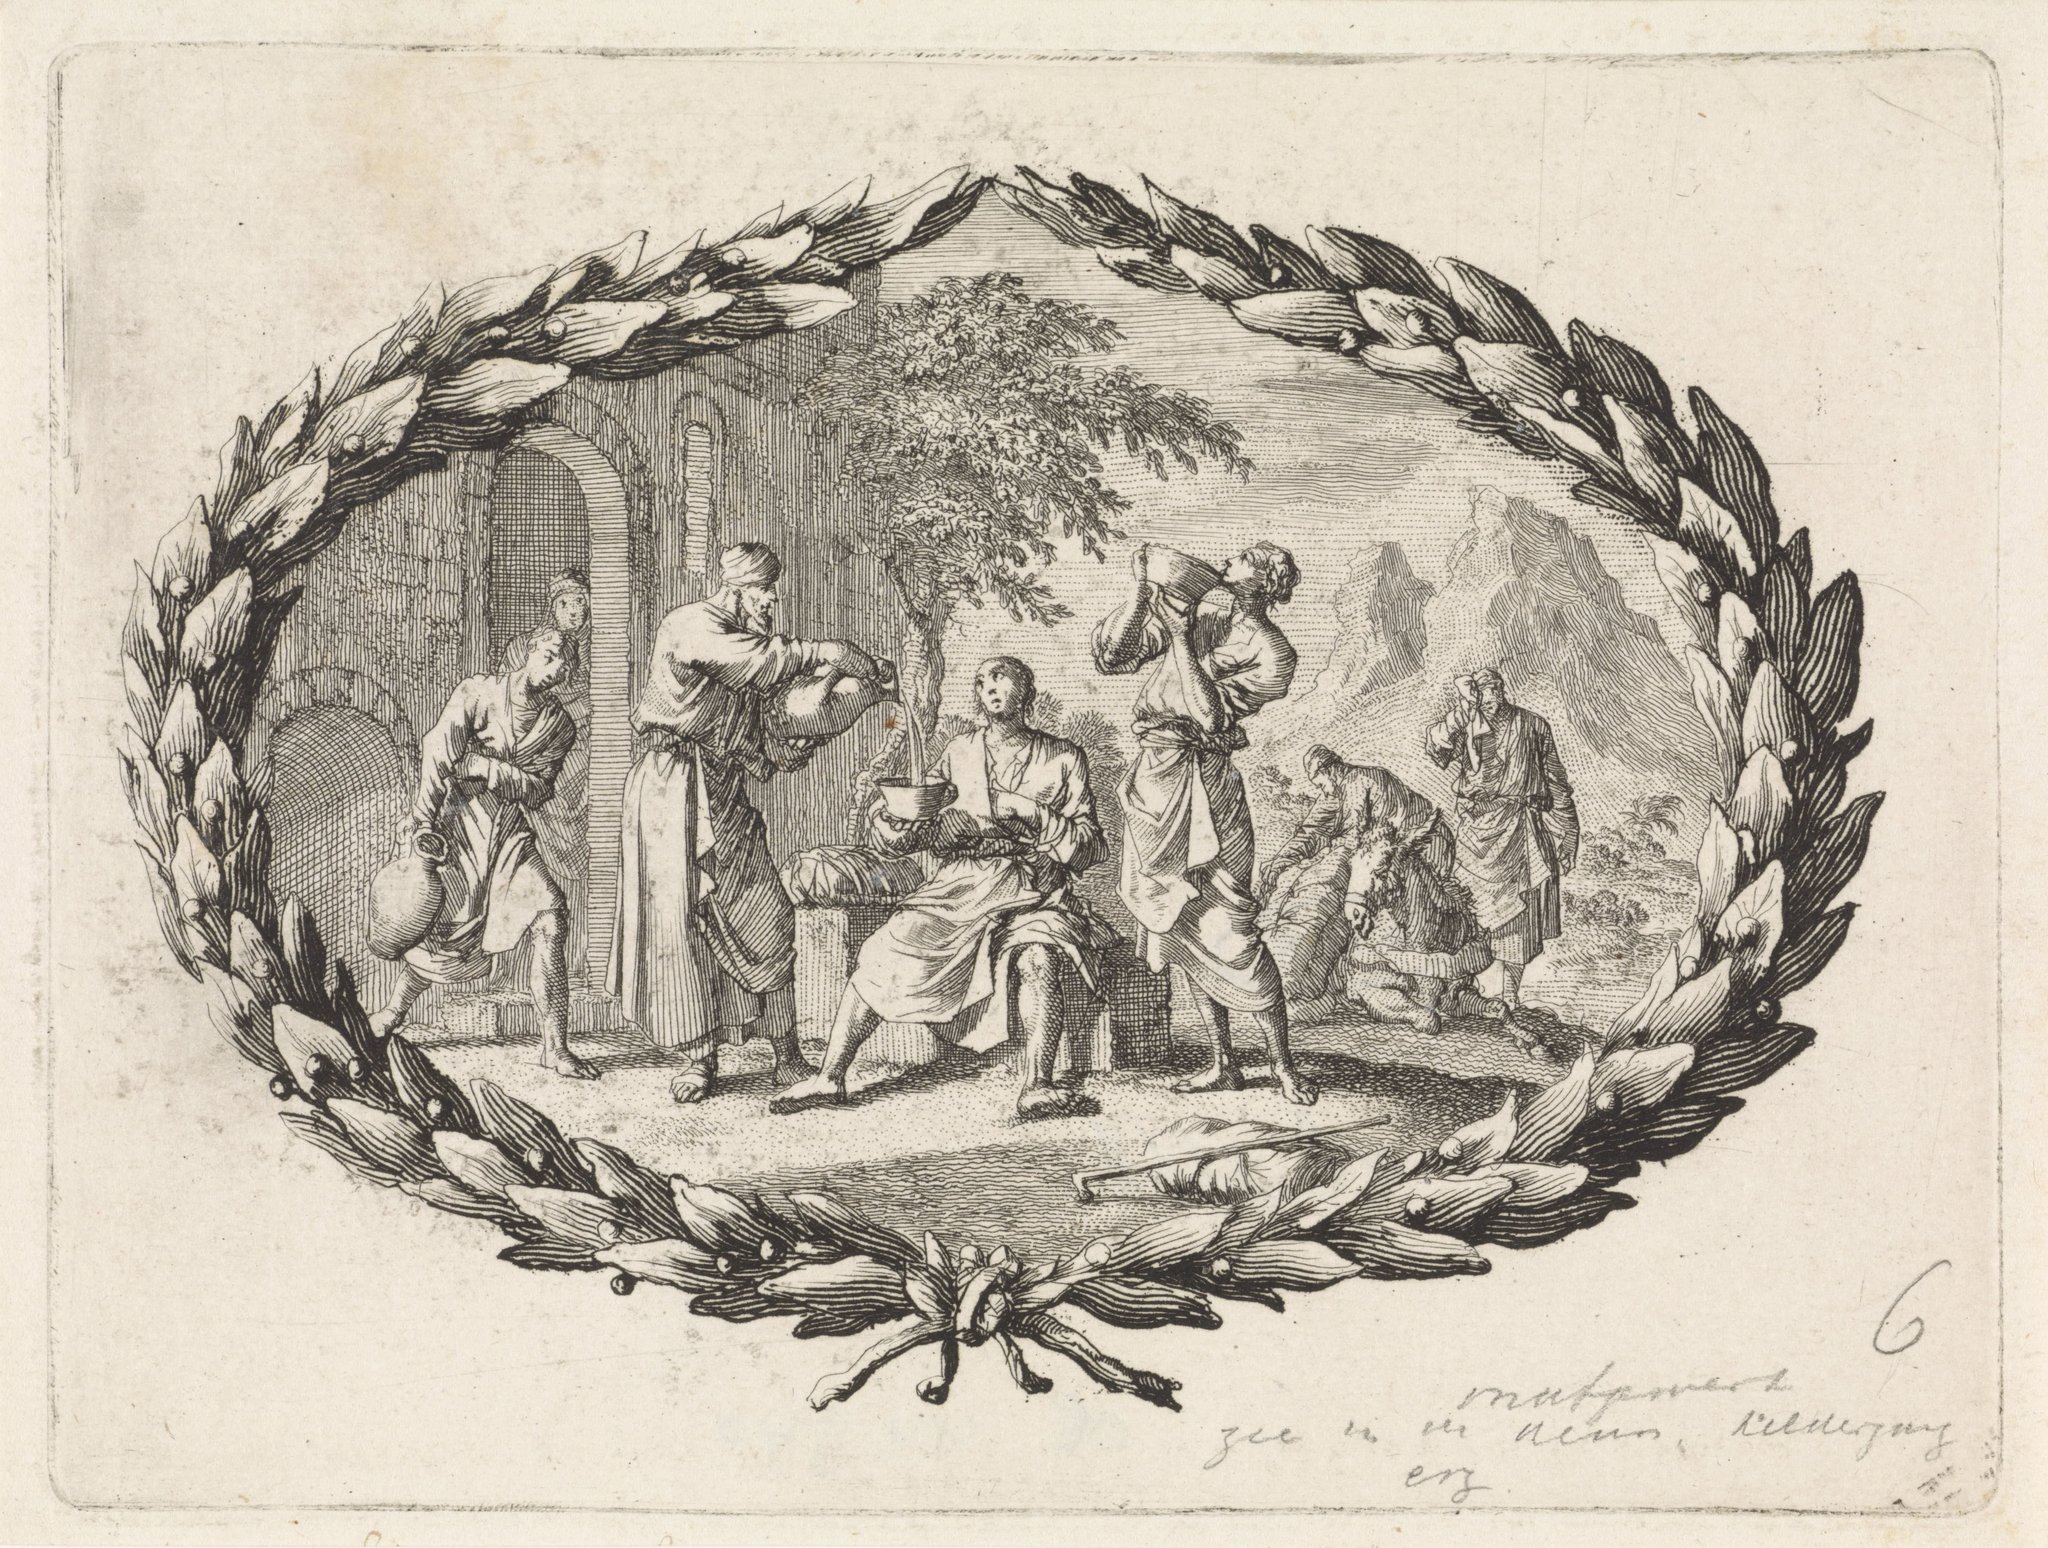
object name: print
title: Dorstigen laven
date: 1700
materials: paper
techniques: etching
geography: amsterdam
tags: ornament ~ cartouche, giving the thirsty to drink, 'sitiens potatur' ~ one of the (seven) acts of mercy, giving drink, drinking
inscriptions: collector's mark: Lugt 2228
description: Een voorstelling in een cartouche van palmtakken. Twee reizigers drinken uit kommen water. De man naast hen schenkt water in de kom en laat zijn knecht meer kruiken met water aandragen. Op de achtergrond twee andere vermoeide reizigers.